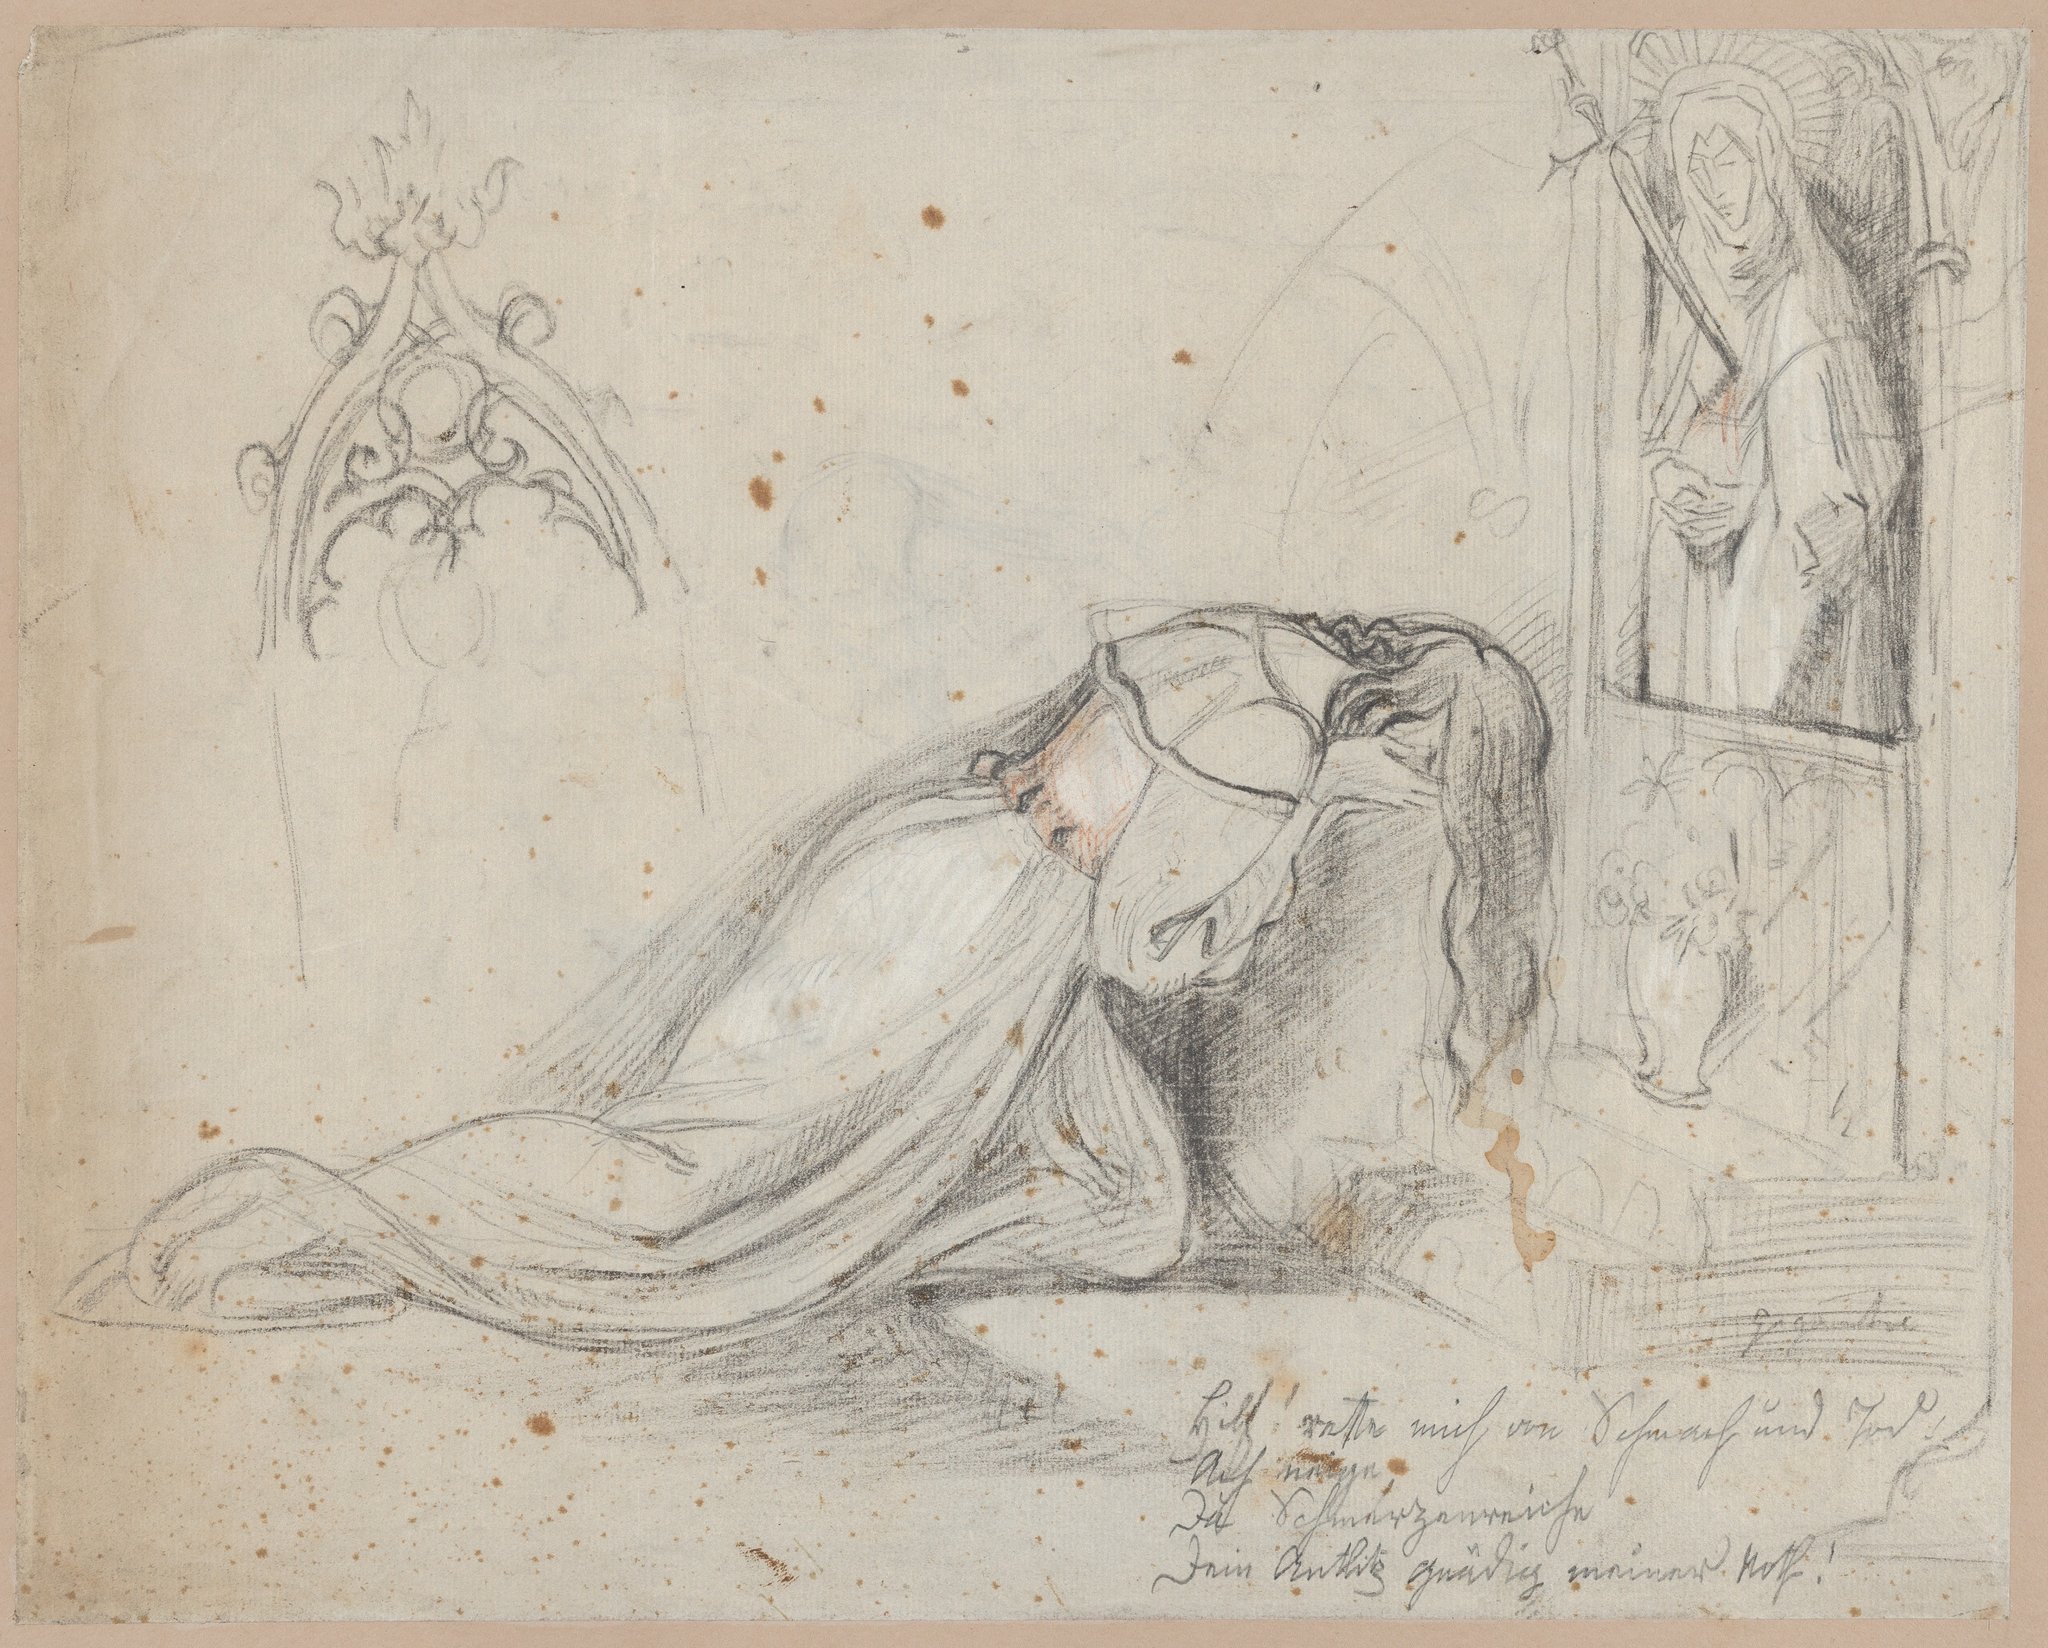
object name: drawing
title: Gretchen in prayer before the Mater Dolorosa (recto). Studies of a Gretchen, a bearded male head, and other figures (verso)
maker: theodor richard edward von holst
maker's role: artist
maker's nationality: british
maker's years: 1810-1844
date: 1828-1831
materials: chalk